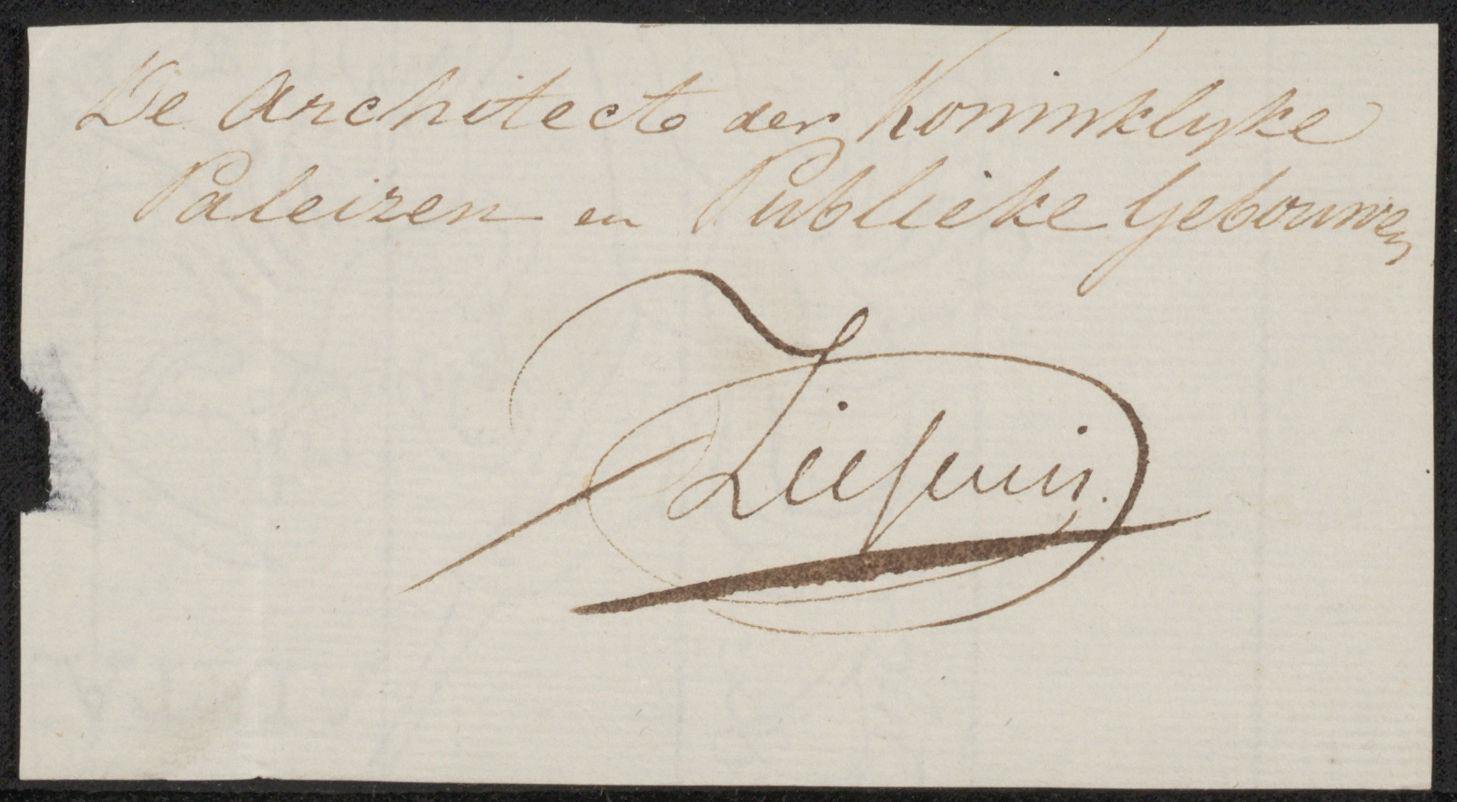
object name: manuscript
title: Handschrift en handtekening van Bartholomeus Ziesenis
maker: bartholomeus ziesenis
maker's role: draughtsman, sculptor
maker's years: 1768-1820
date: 1778-1820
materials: ink, paper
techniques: pen, writing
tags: architecture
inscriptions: watermark